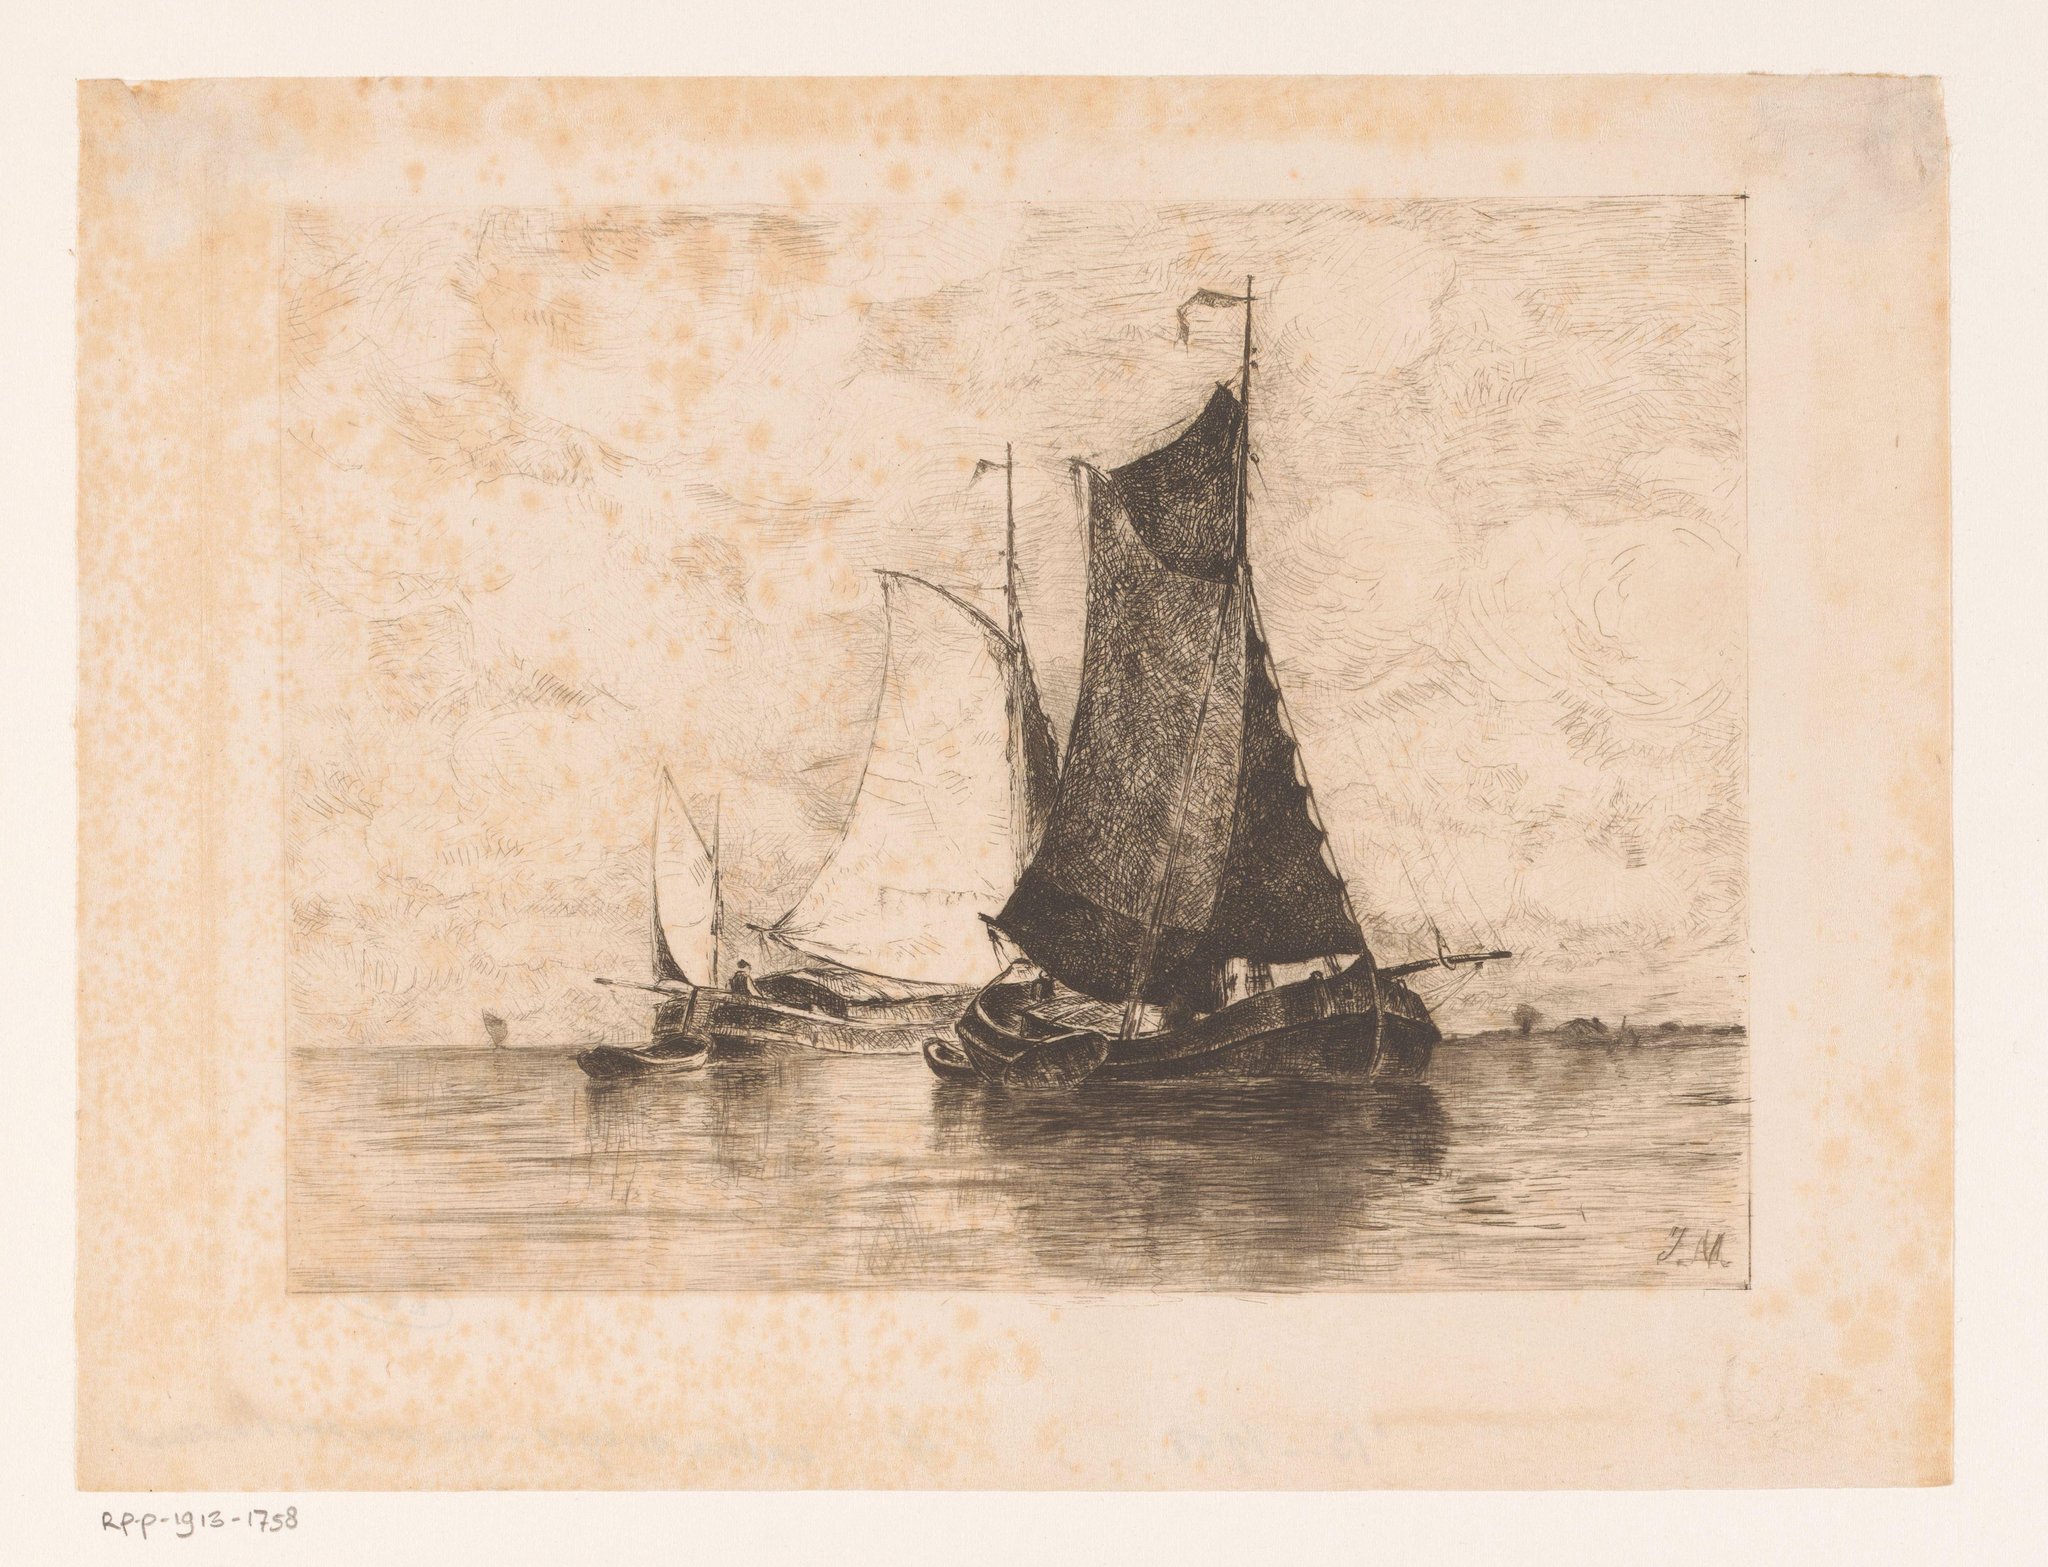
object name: print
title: Schepen op de Schelde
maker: isidore meyers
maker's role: print maker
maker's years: 1836-1917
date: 1846-1913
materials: paper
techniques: drypoint, etching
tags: sailing-ship, sailing-boat, landscapes with waters, waterscapes, seascapes (in the temperate zone)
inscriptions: collector's mark: Lugt 2228, mark: ‘Antwerpsche Etsers 1880’